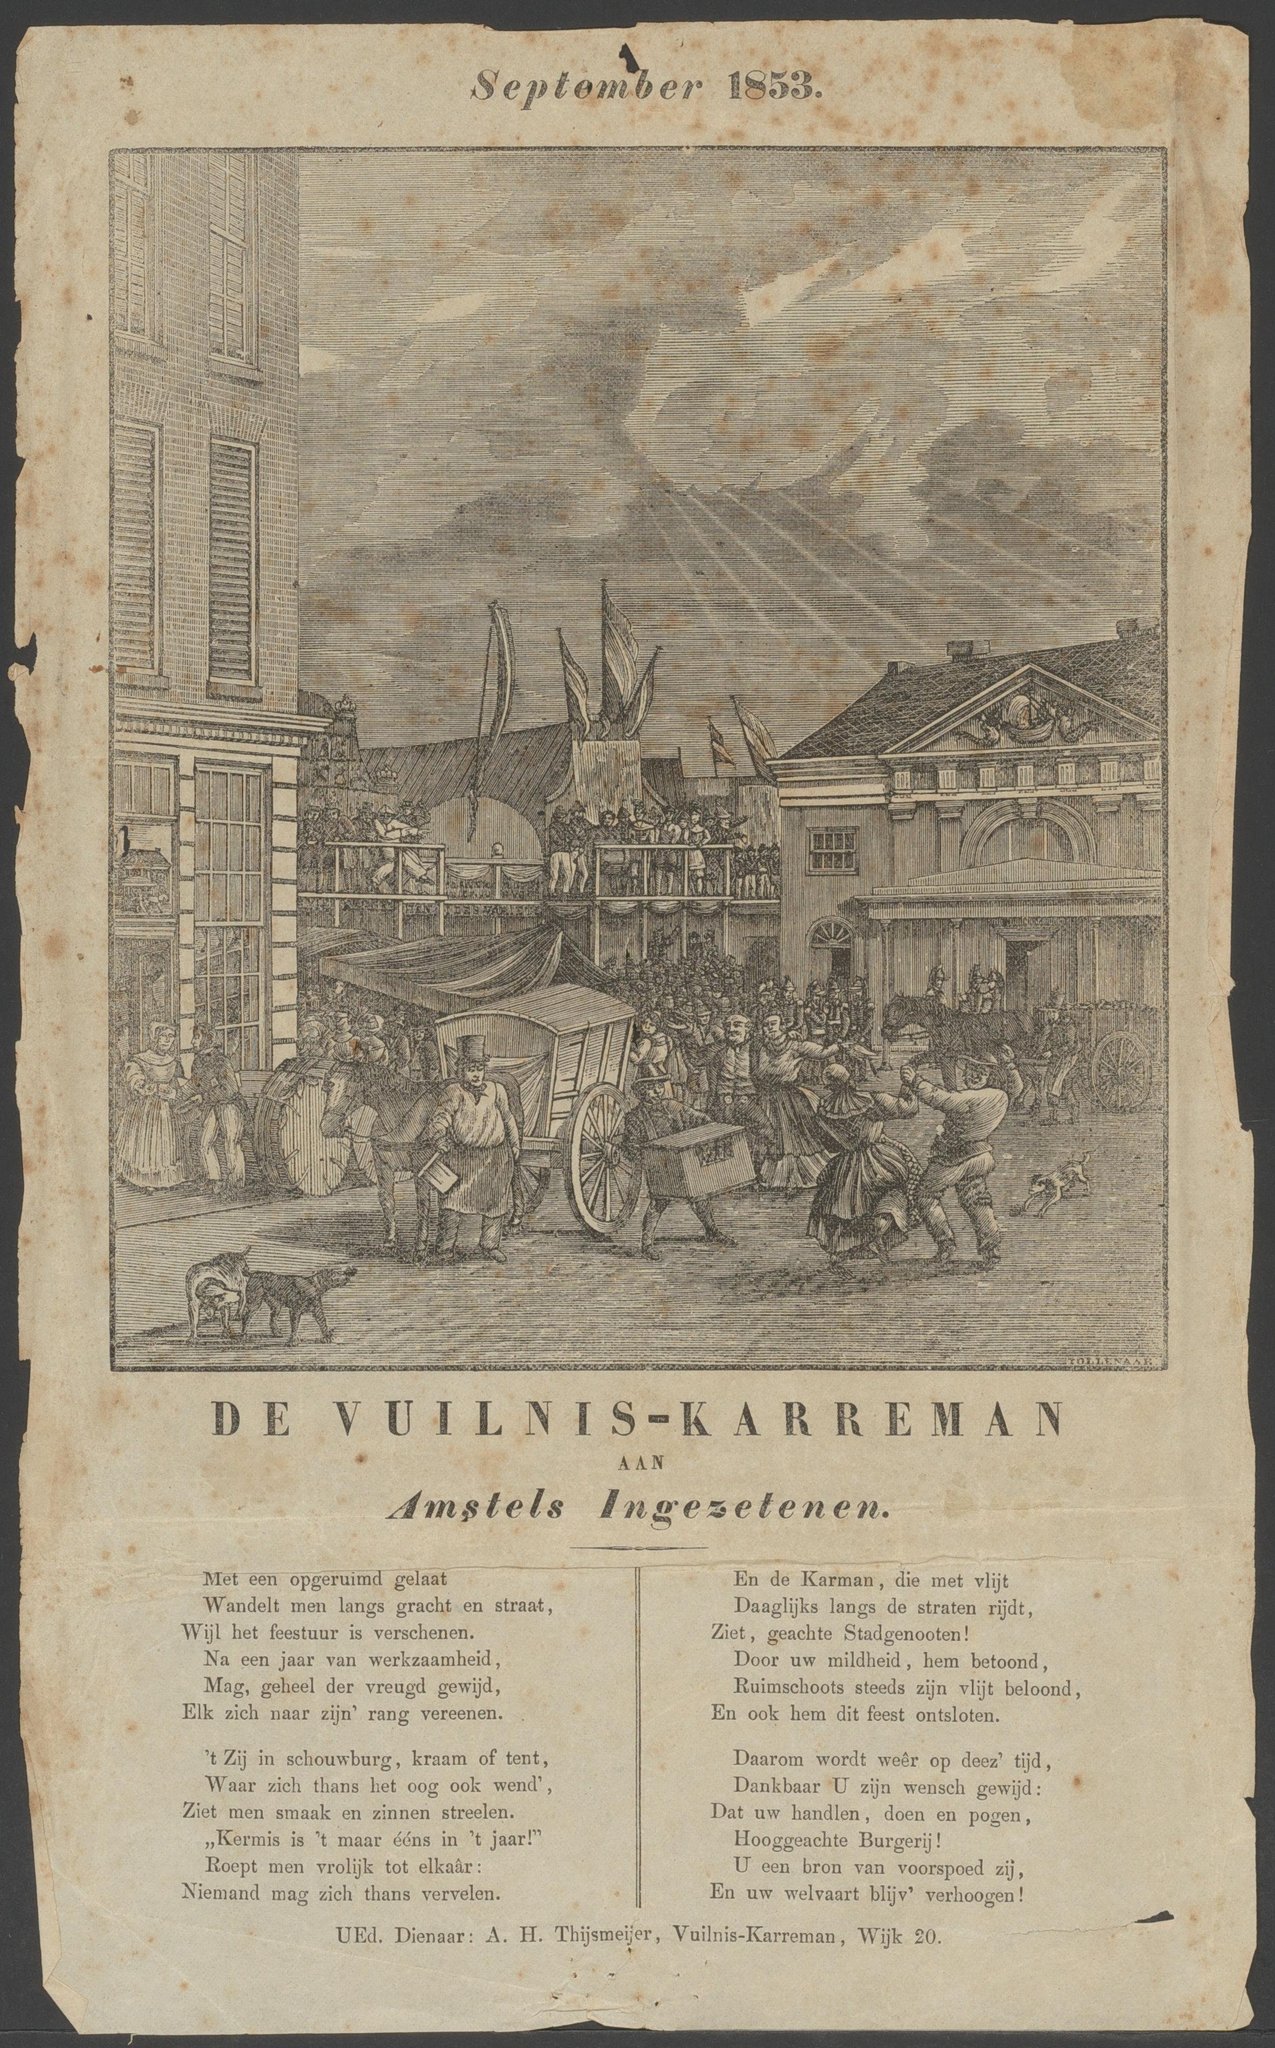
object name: fair print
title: Kermisprent van de vuilnismannen van Amsterdam voor het jaar 1853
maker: dirk wijbrand tollenaar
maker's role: print maker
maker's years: 1808-1858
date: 1853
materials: paper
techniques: letterpress printing, engraving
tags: street, garbage collection, amsterdam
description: Kermisprent van de Amsterdamse vuilnismannen voor het jaar 1853. Gezicht op de kermis op de Botermarkt met de oude Waag. Op de markt twee vuilniskarren. Met gedicht in twee kolommen. Van de vuilniskarman in de wijk no. 20: A.H. Thijsmeijer. Onderwerpsrubrieken binnen de Atlas Zeden en Gewoonten: Zeden en gewoonten in engeren zin, Volksleven, Volksbladen, Nieuwjaars- en Kerstwenschen, Amsterdam.